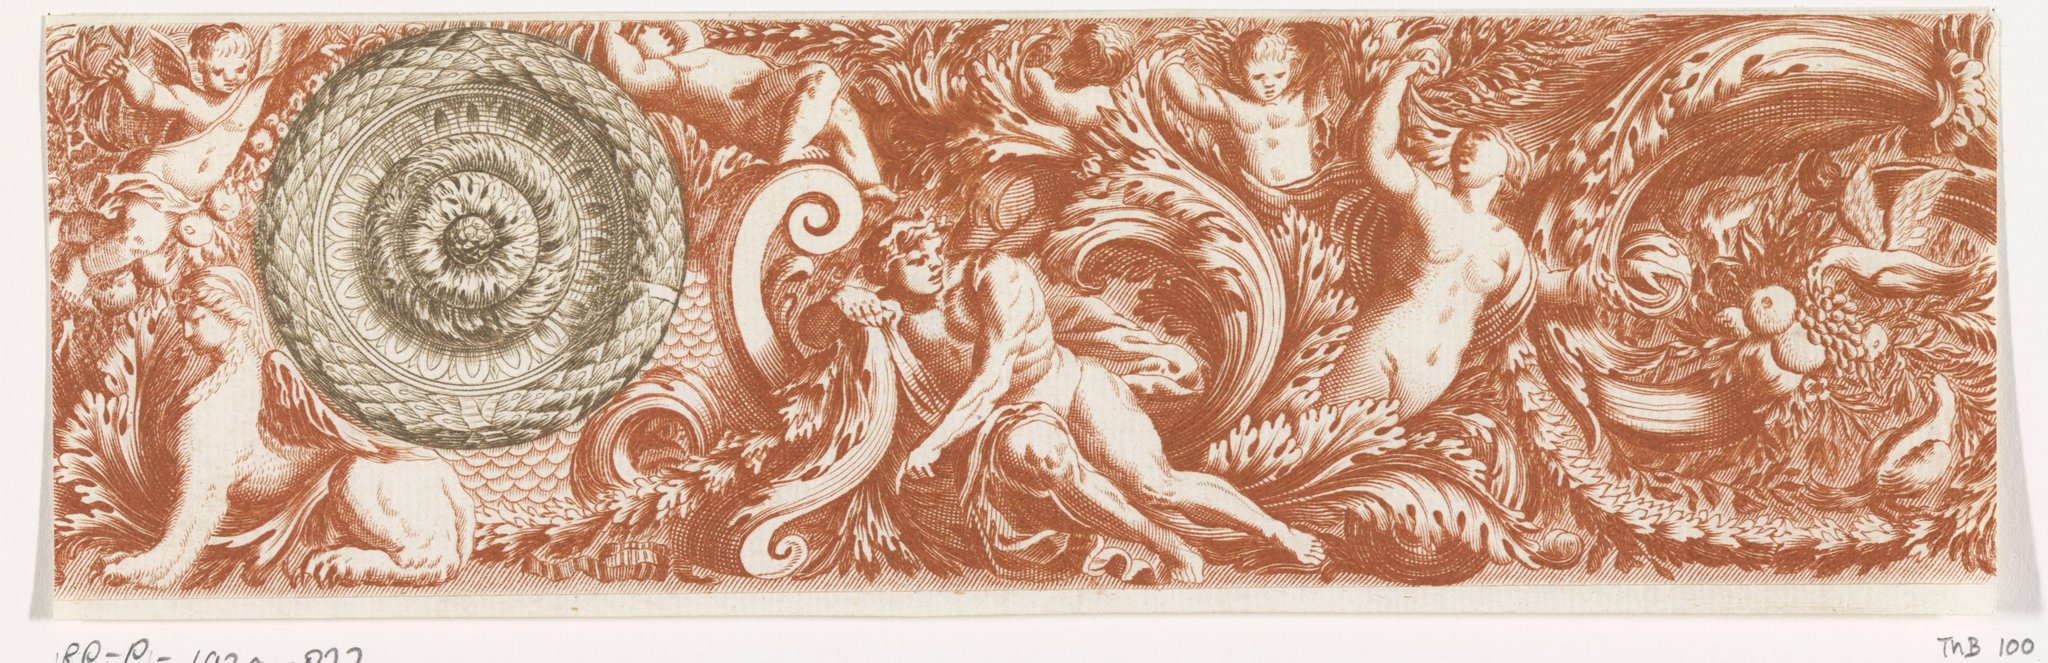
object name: print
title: Ornamenteel fries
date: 1688-1698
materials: paper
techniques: printing, engraving, lithography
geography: netherlands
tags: rosette ~ ornament, sphinx (lion/woman); 'sfinge' (ripa), cupids: 'amores', 'amoretti', 'putti'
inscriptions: collector's mark: Lugt 2228, collector's mark: Lugt 2760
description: Fries met ornamentele plantmotieven, een sfinx, een naakte man- en vrouwfiguur, Amor en drie putti. Links een rozet.